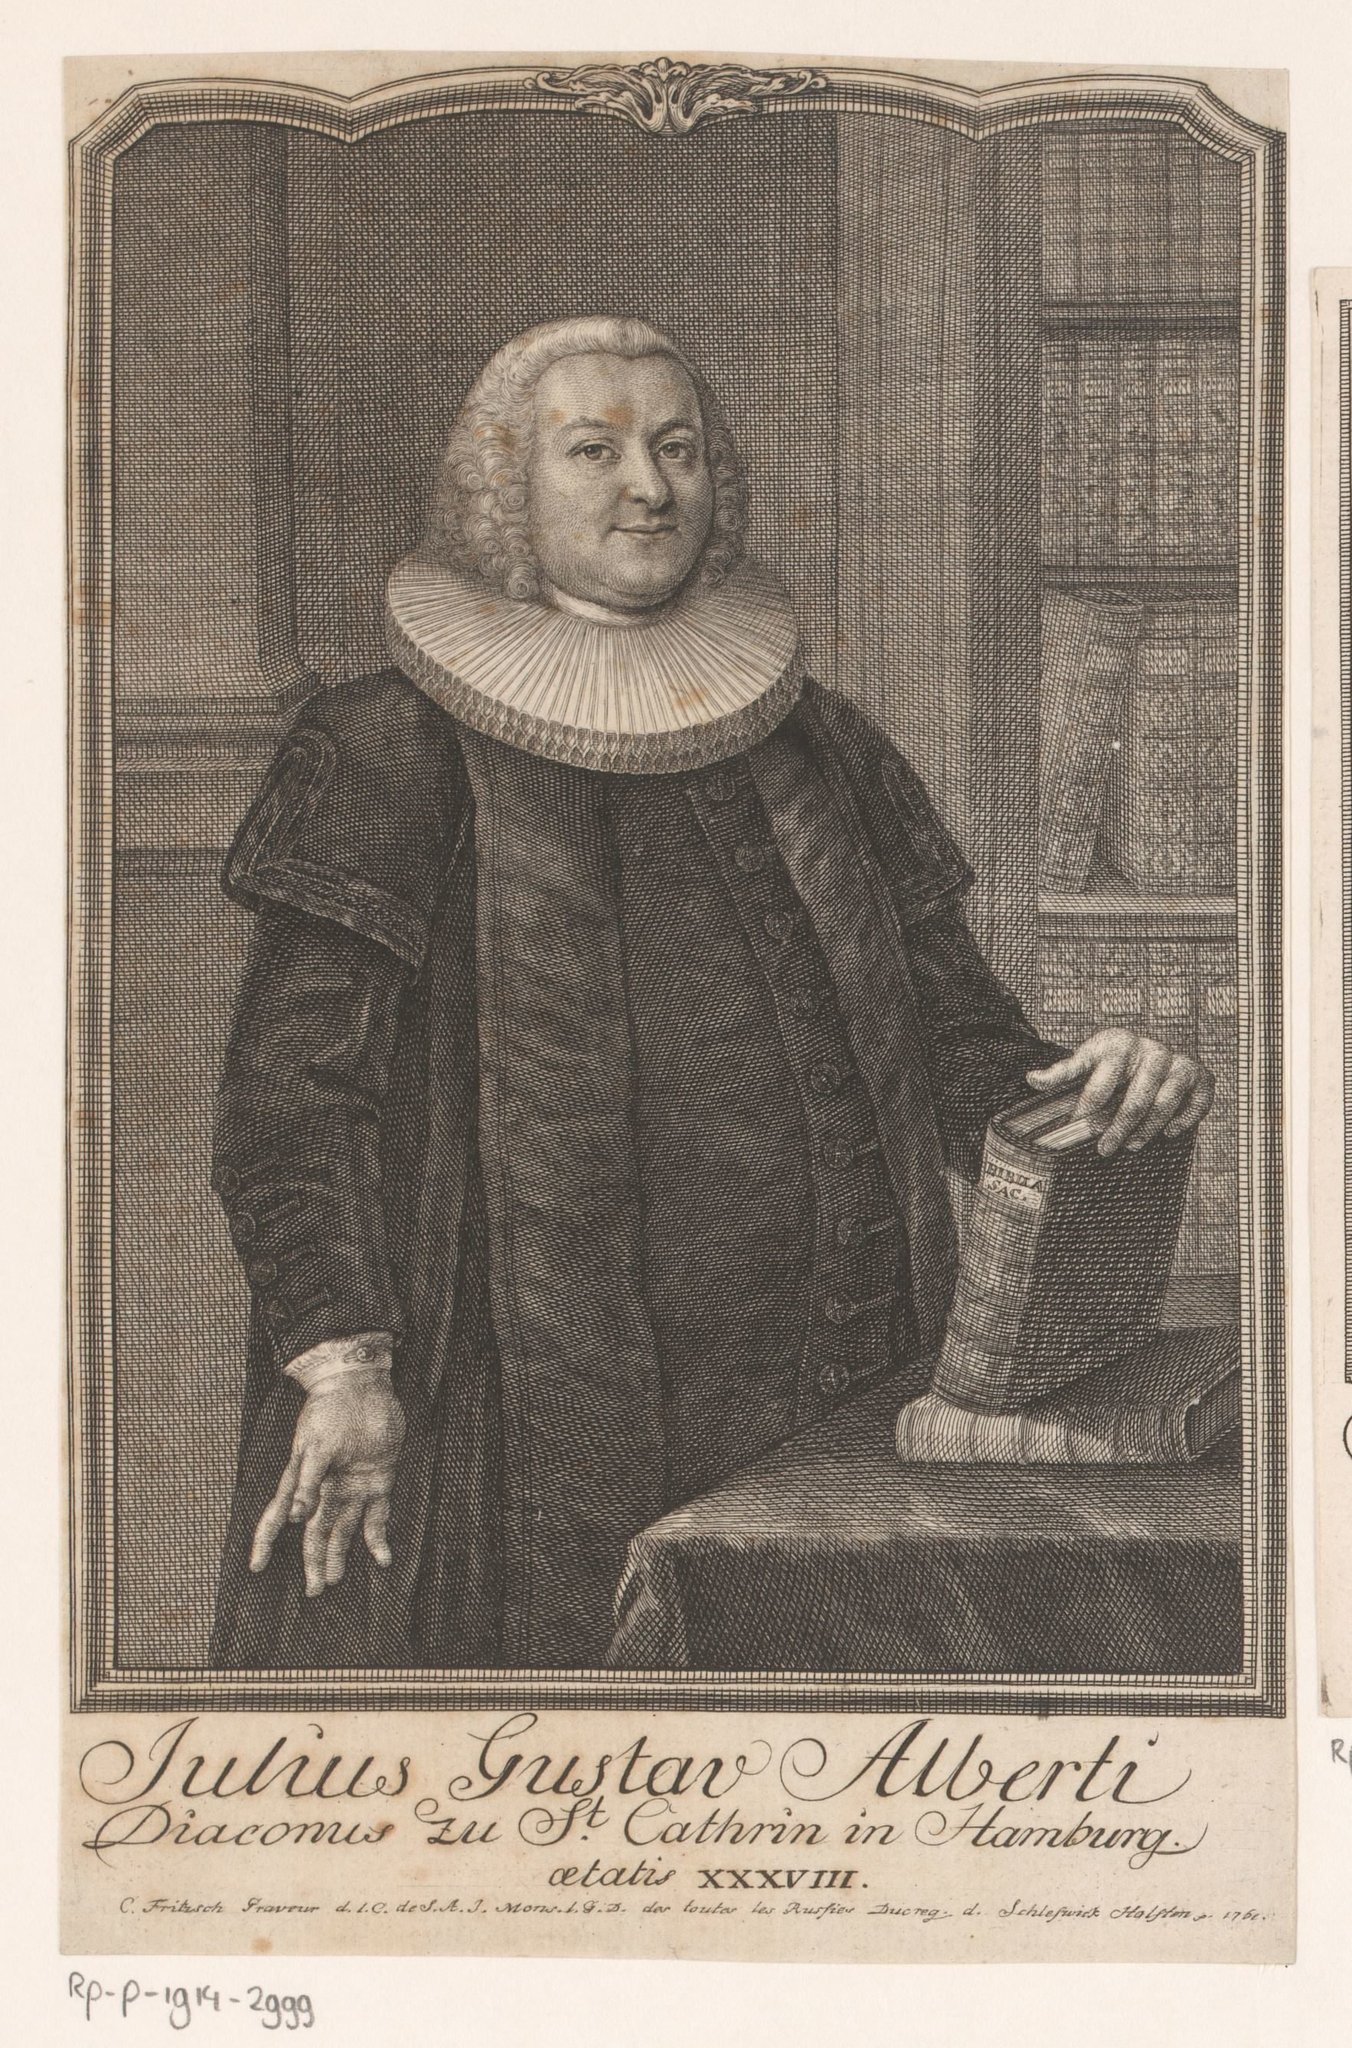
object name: print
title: Portret van Julius Gustav Alberti op 38-jarige leeftijd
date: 1761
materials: paper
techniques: engraving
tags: bookshelves, theologian, historical persons, book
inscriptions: collector's mark: Lugt 2228